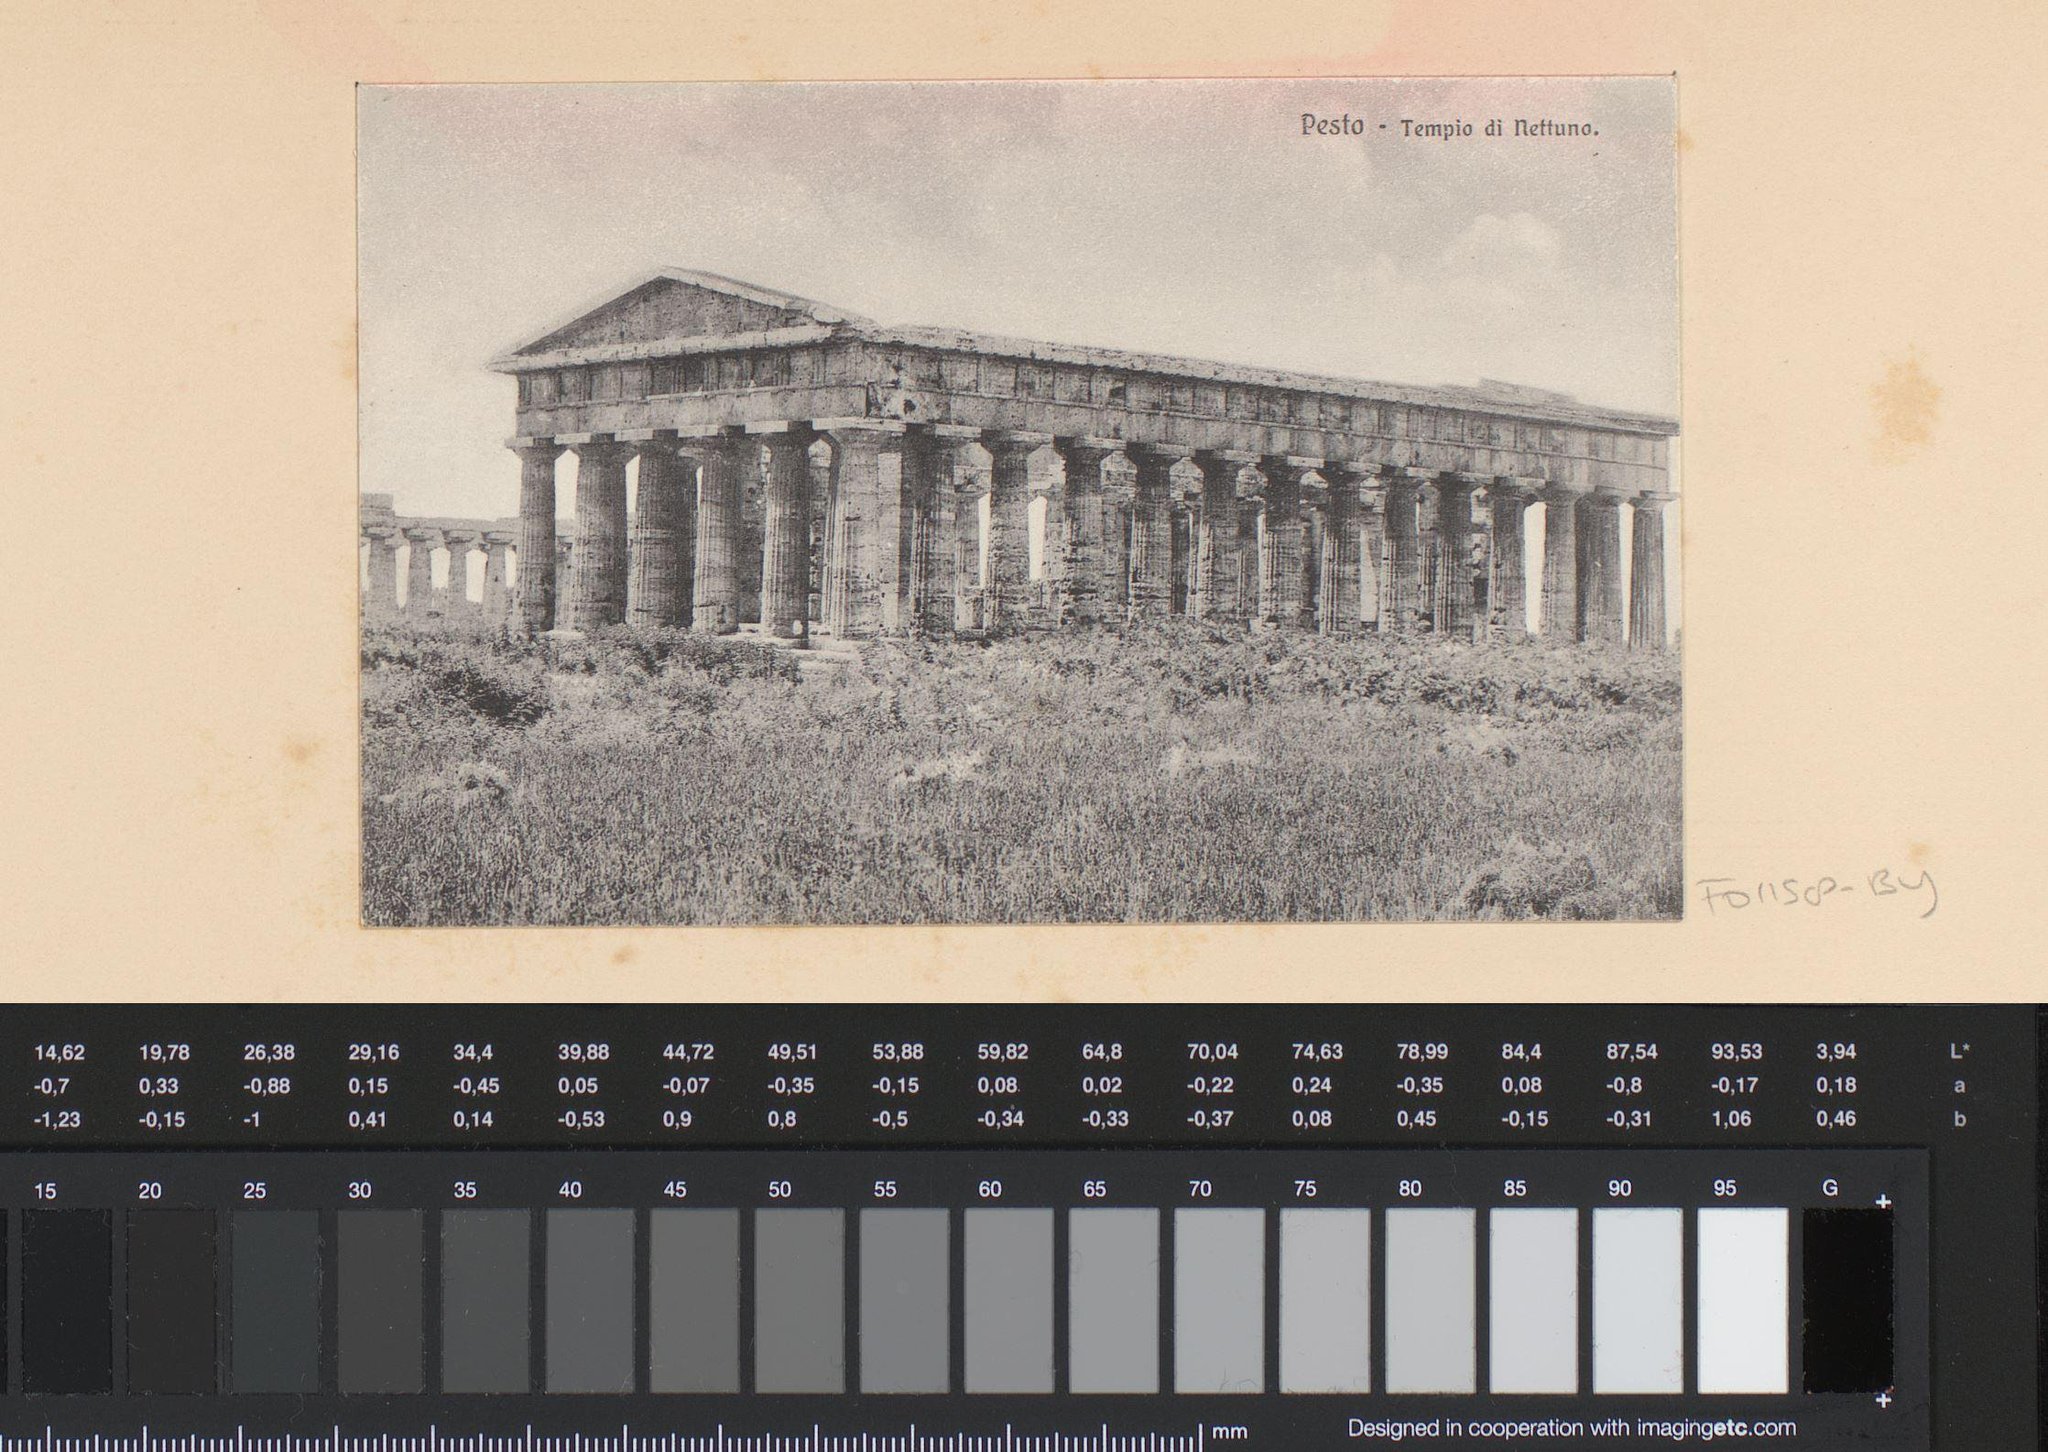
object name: ansichtkaart, prentbriefkaart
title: Exterieur van de Tempel van Poseidon te Paestum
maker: Anonymous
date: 1875-1907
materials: paper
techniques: photograph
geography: paestum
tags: façade (of house or building), temple, shrine ~ greek religion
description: Onderdeel van Fotoalbum met opnames van bezienswaardigheden en kunstwerken in Italië.